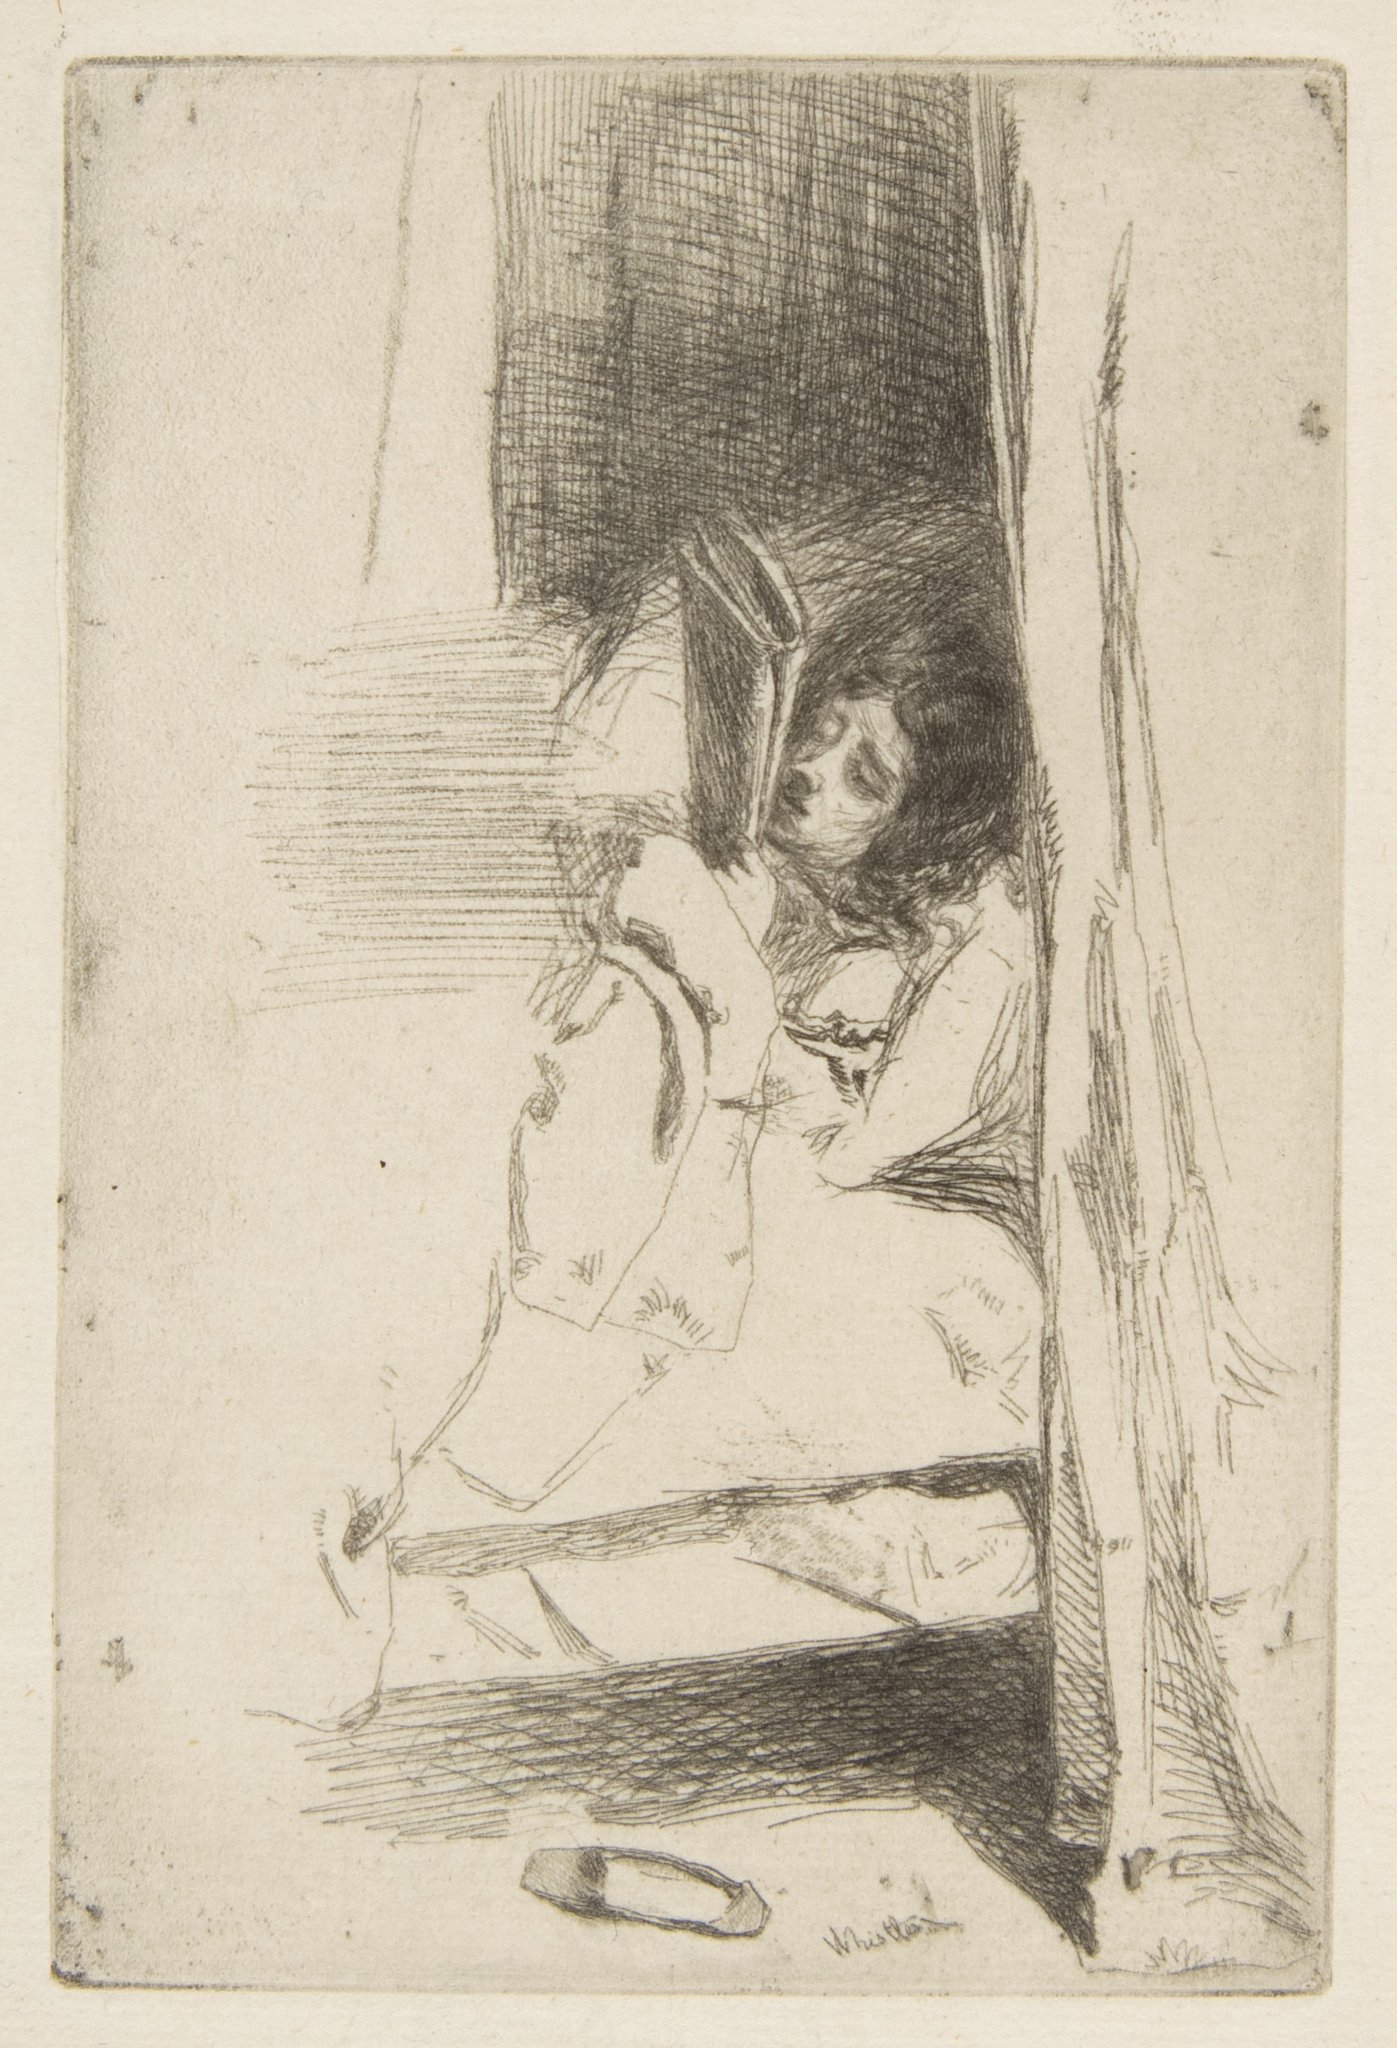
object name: print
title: Reading in Bed (The Slipper)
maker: james mcneill whistler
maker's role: artist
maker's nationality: american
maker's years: 1834-1903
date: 1858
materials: ink, paper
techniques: drypoint, etching, printing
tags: women,reading,beds